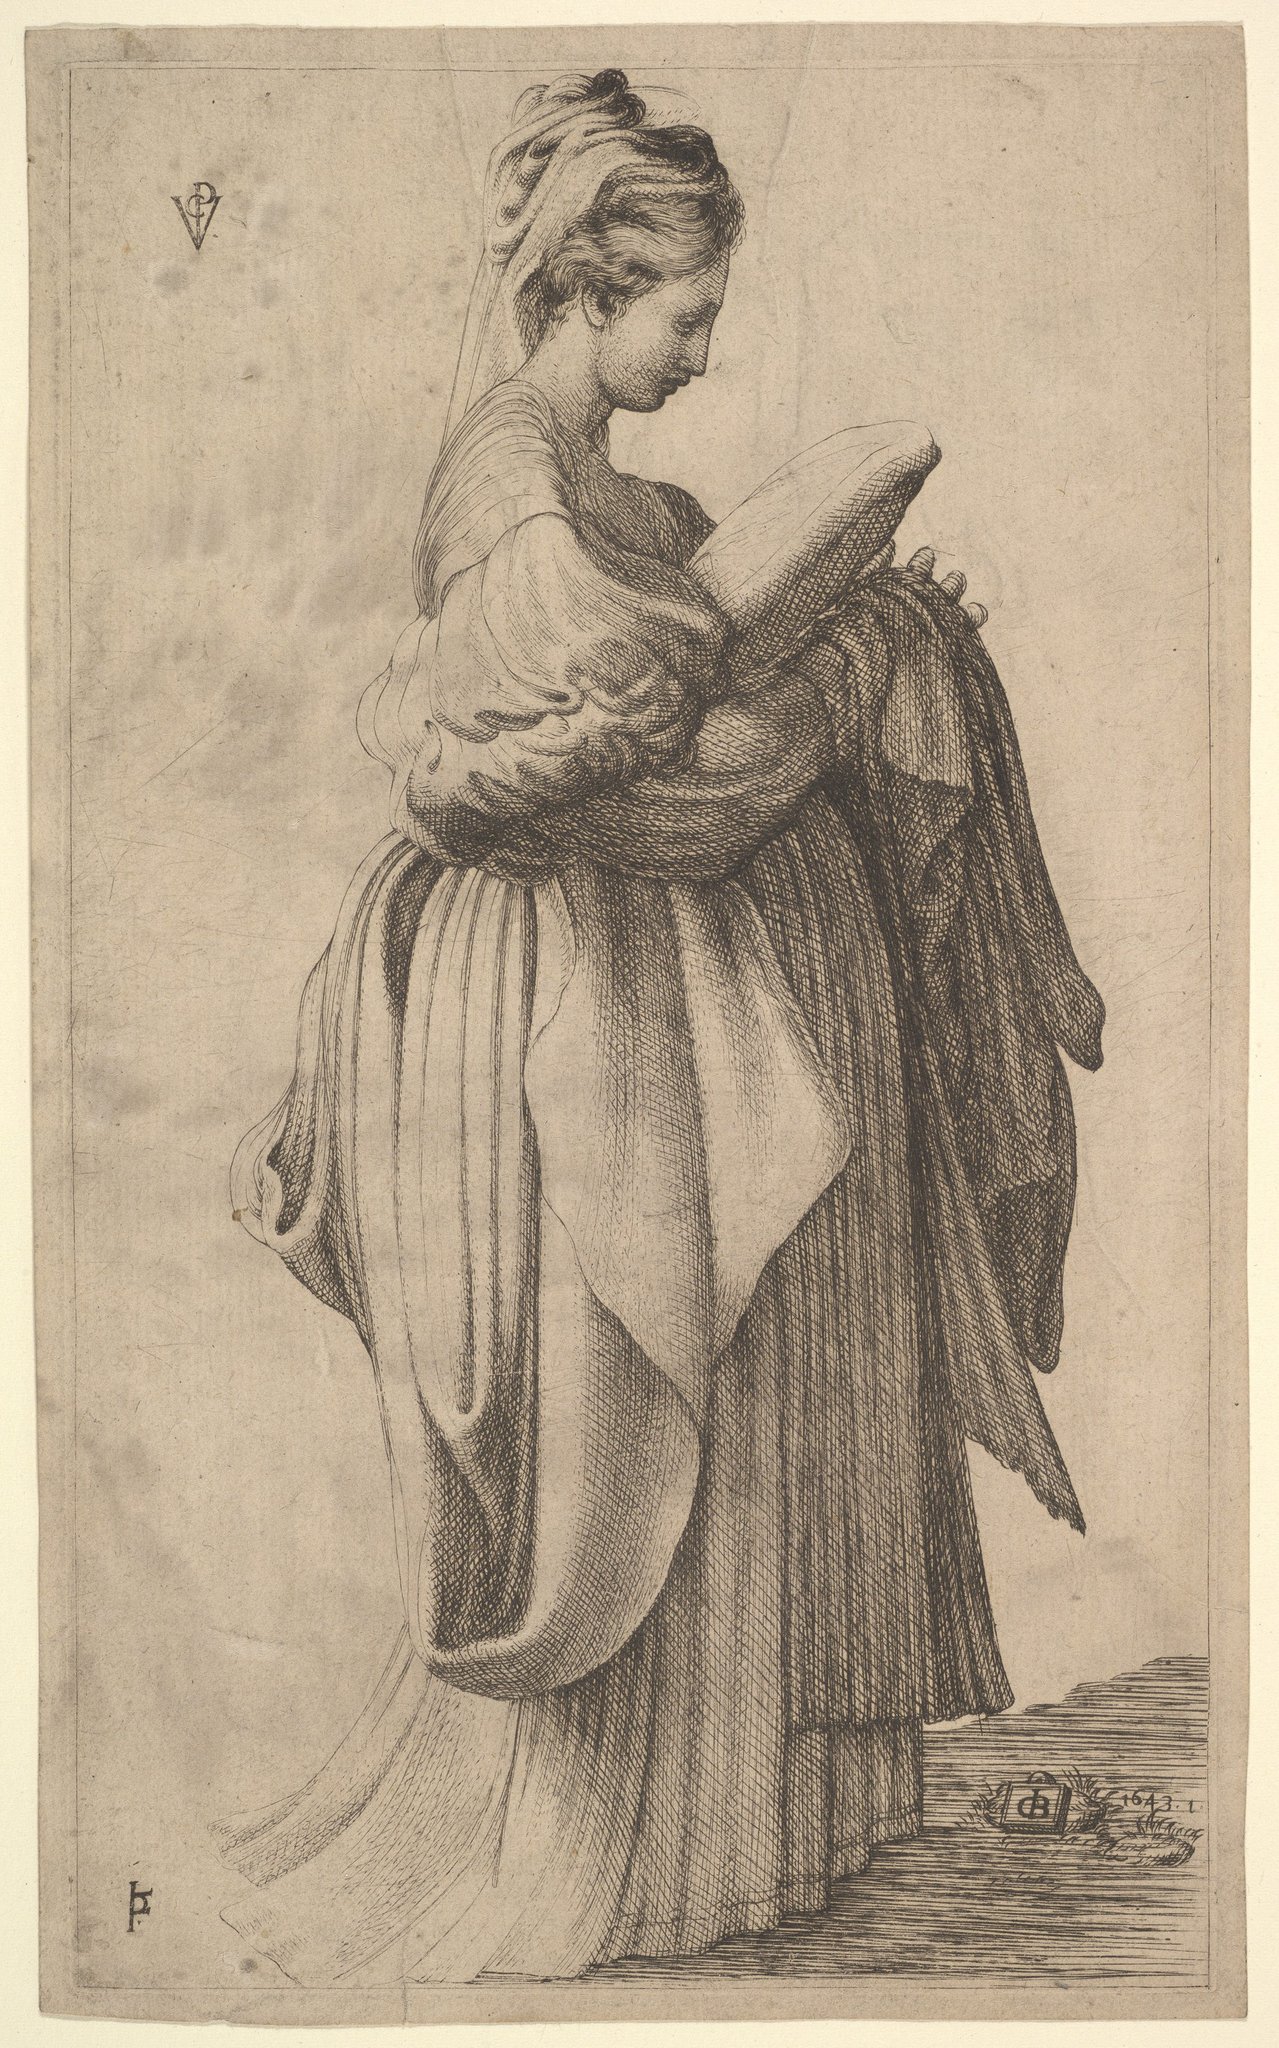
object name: print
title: Female Figure holding a Cushion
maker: monogrammist vcp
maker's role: engraver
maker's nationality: italian (?)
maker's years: 1640-1650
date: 1643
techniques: engraving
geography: germany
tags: women